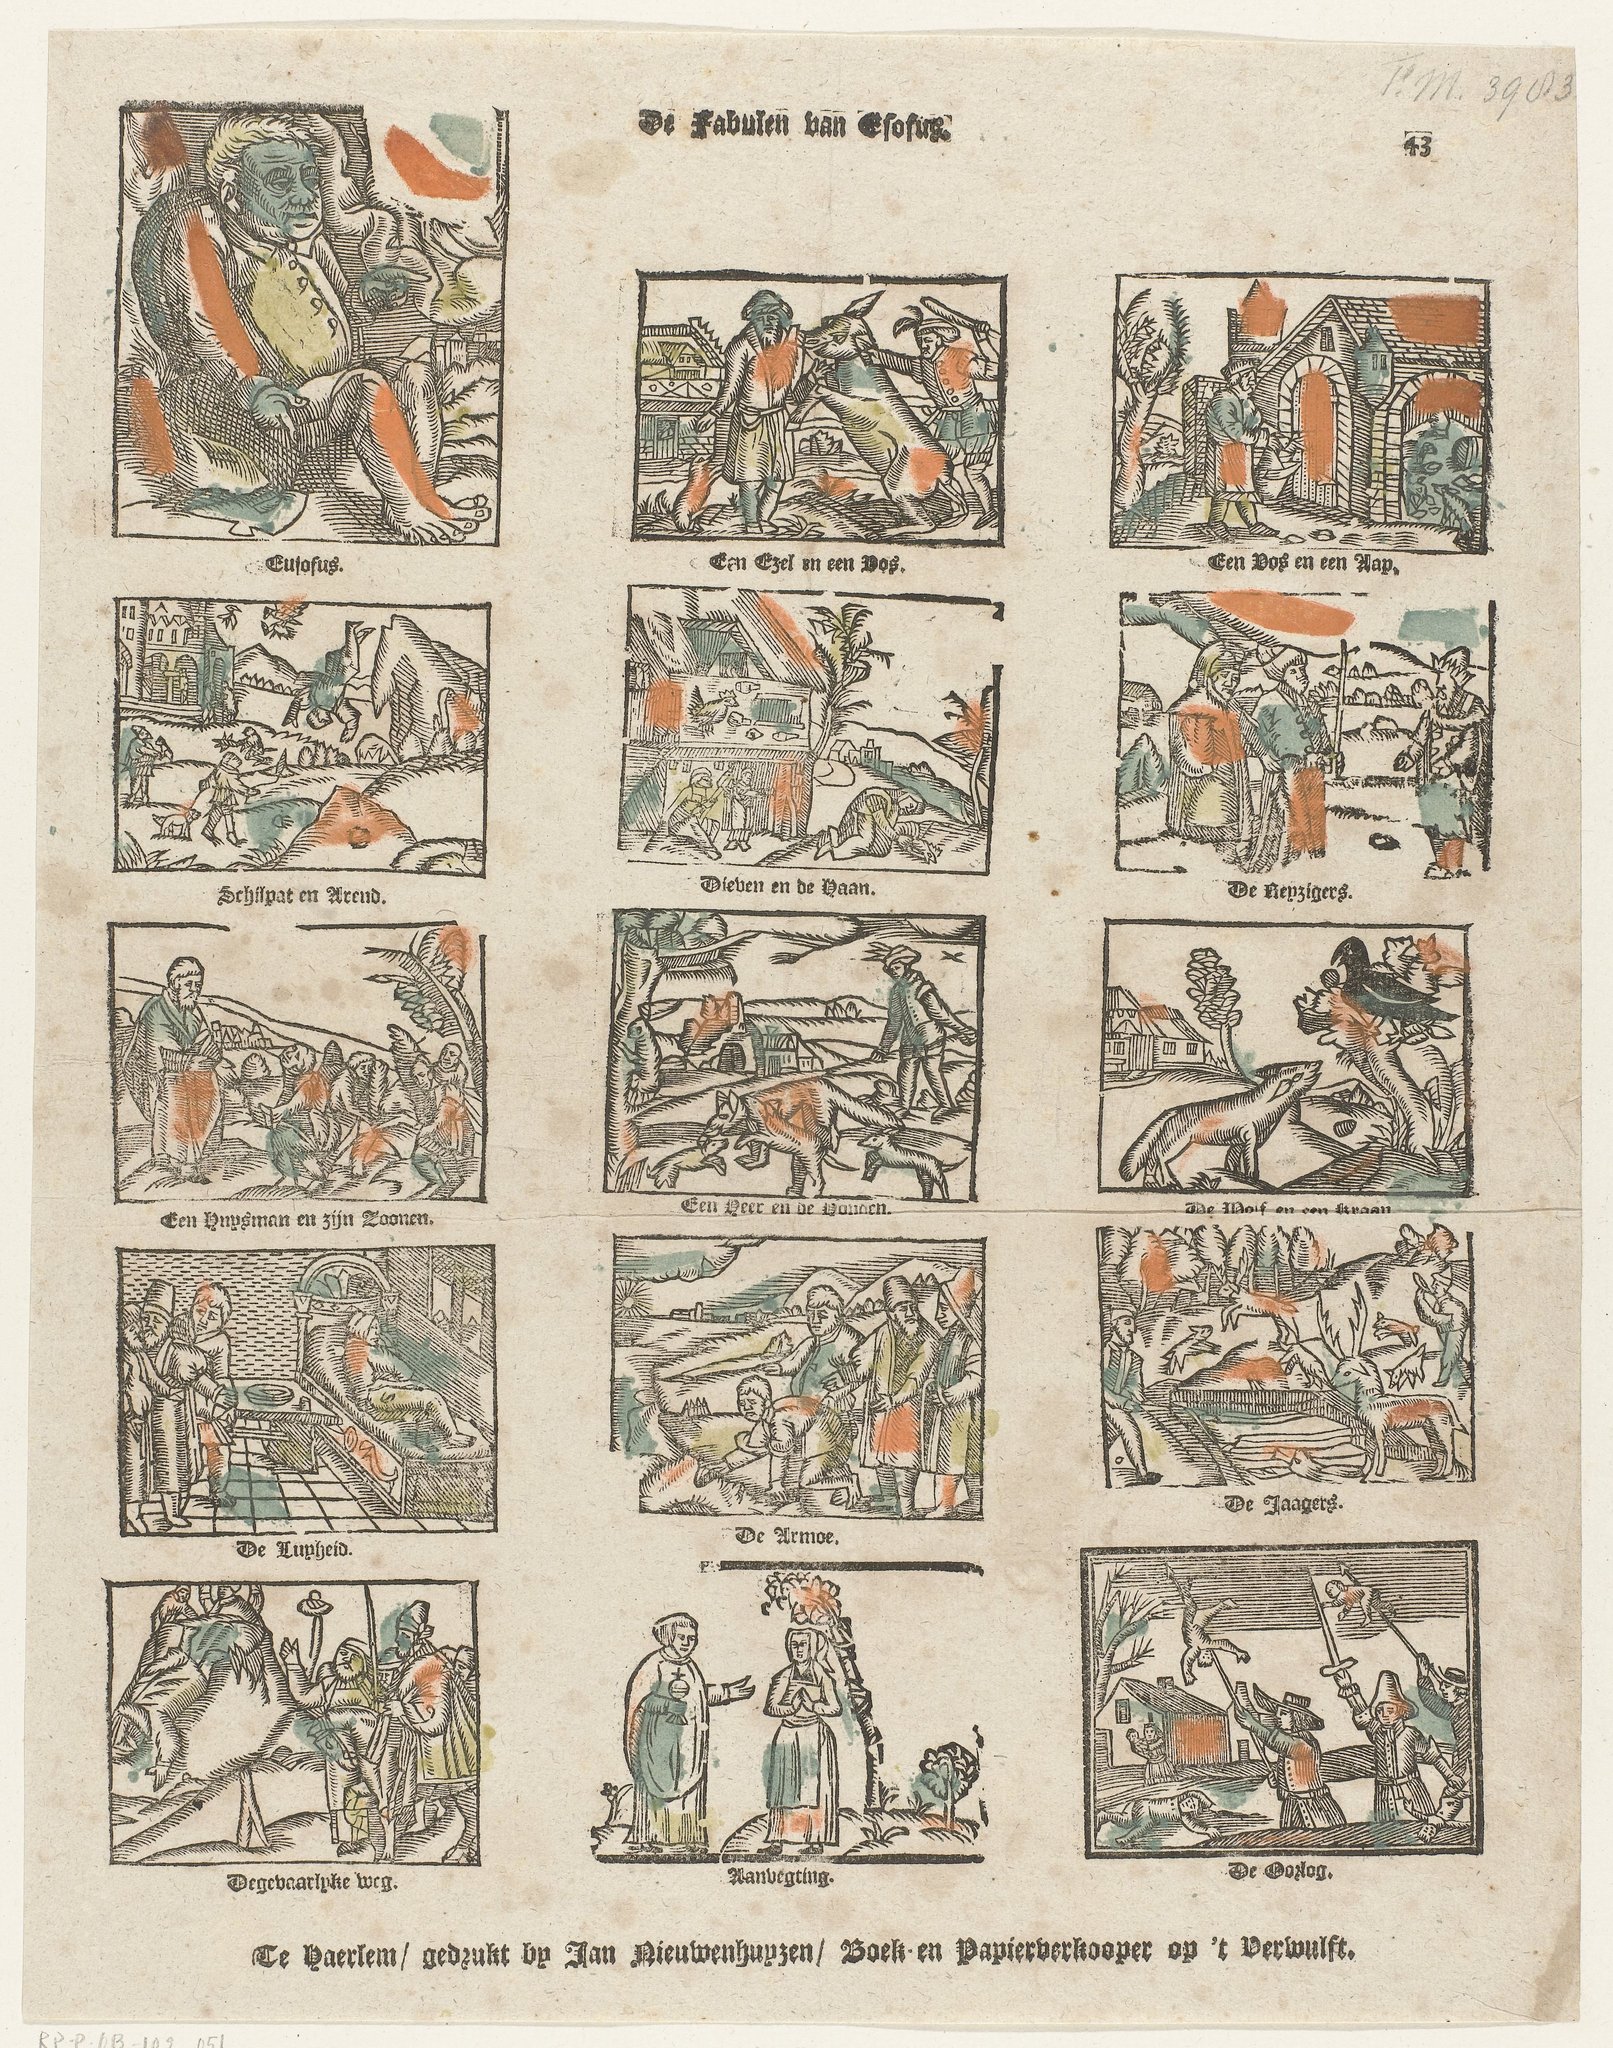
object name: print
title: De Fabulen van Esofus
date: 1743-1758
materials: paper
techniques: colour, letterpress printing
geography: haarlem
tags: fables of aesop : use 85(...)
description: Blad met 15 voorstellingen met een portret van Aesopus, illustraties uit zijn fabels en enkele allegorische voorstellingen. Onder elk plaatje een titel. Genummerd rechtsboven: 43.